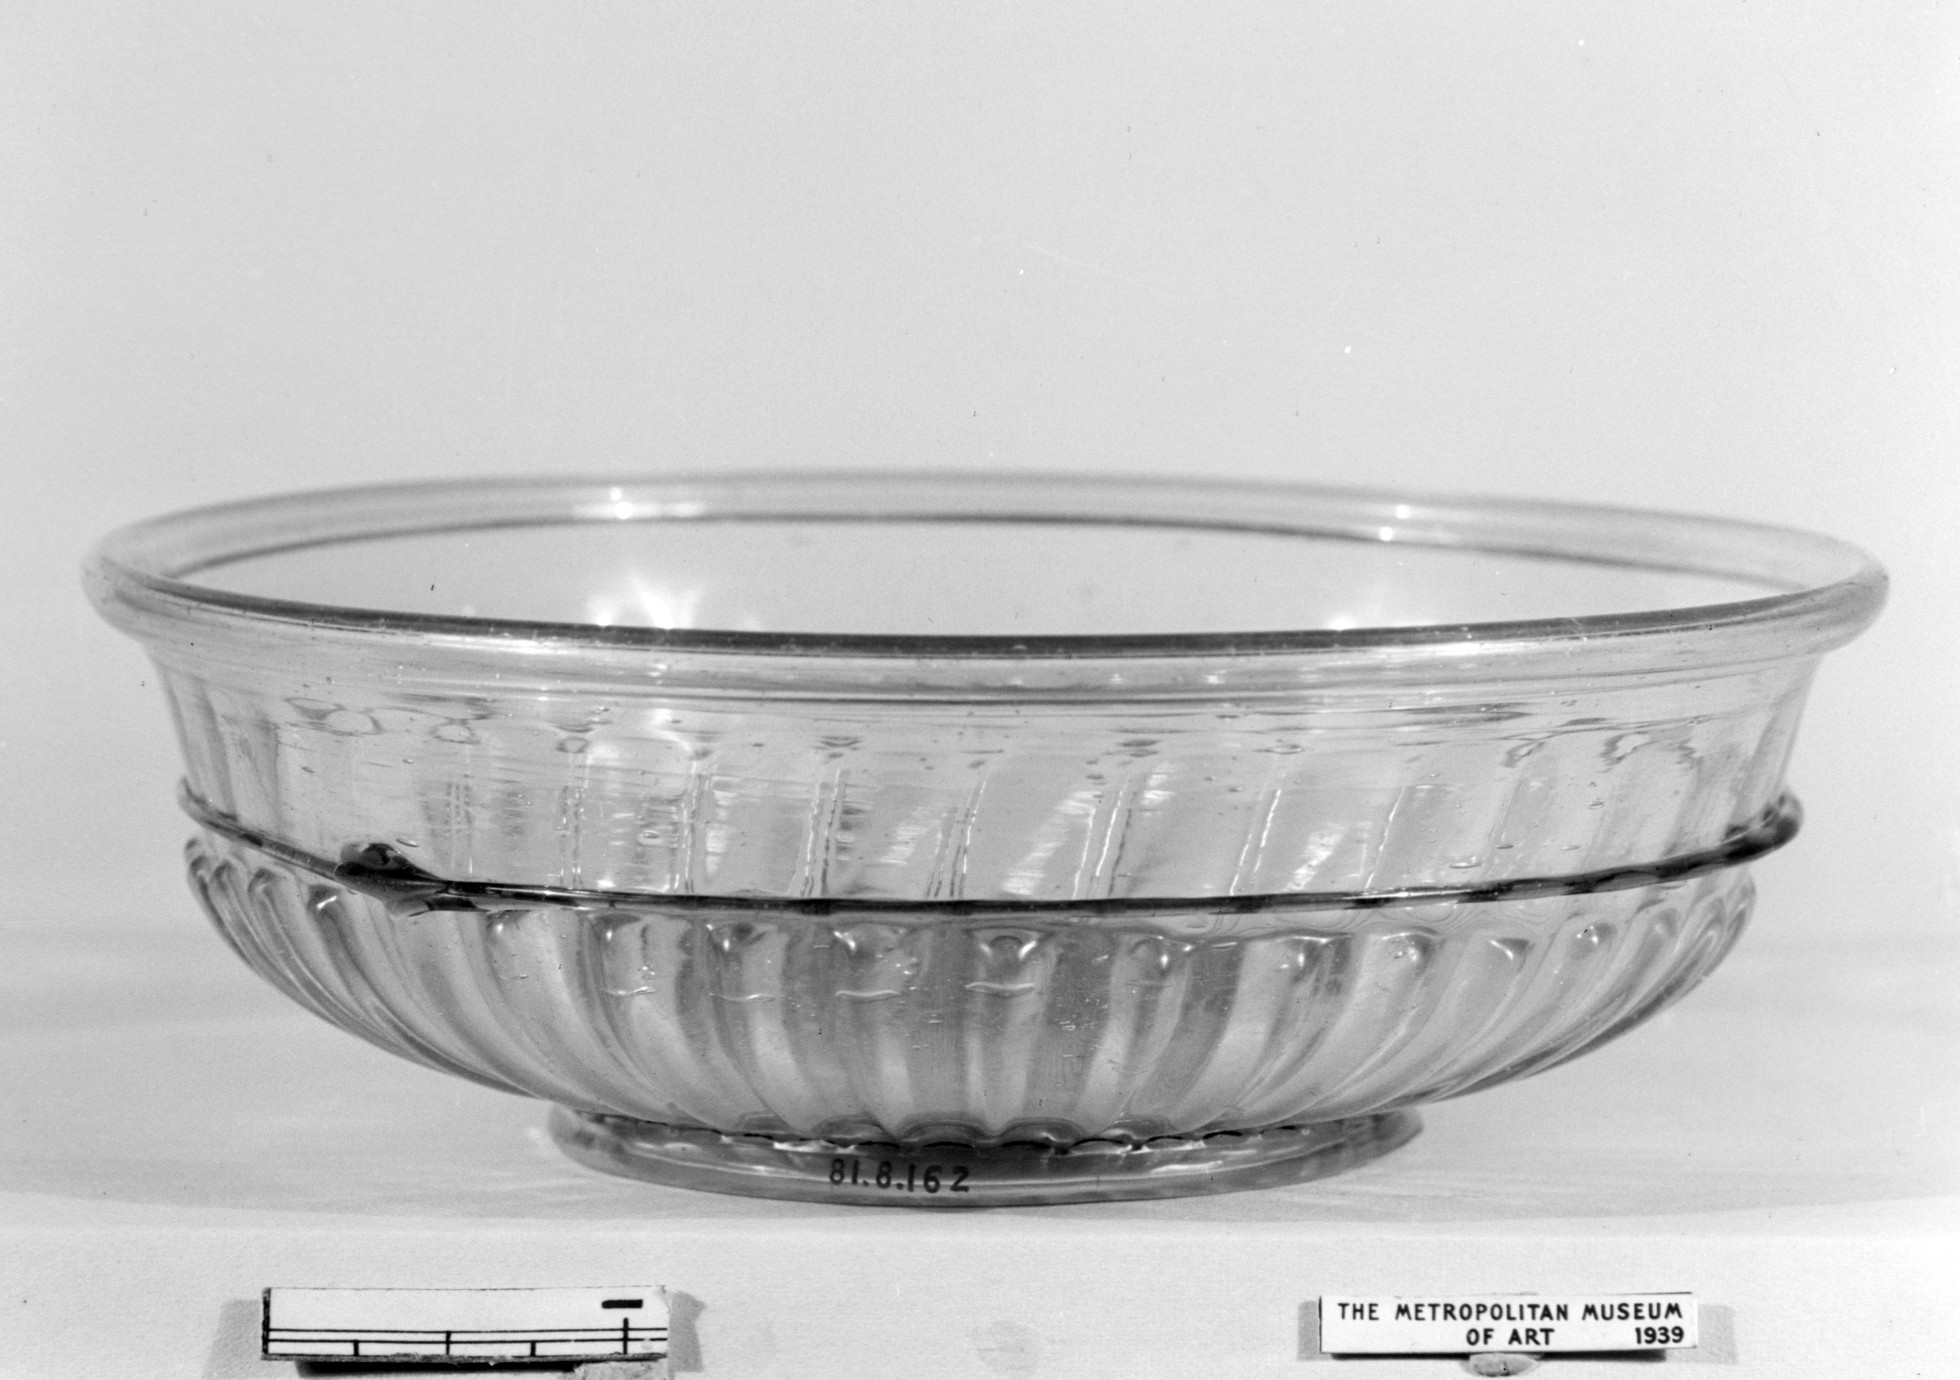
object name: bowl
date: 1501-1550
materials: glass